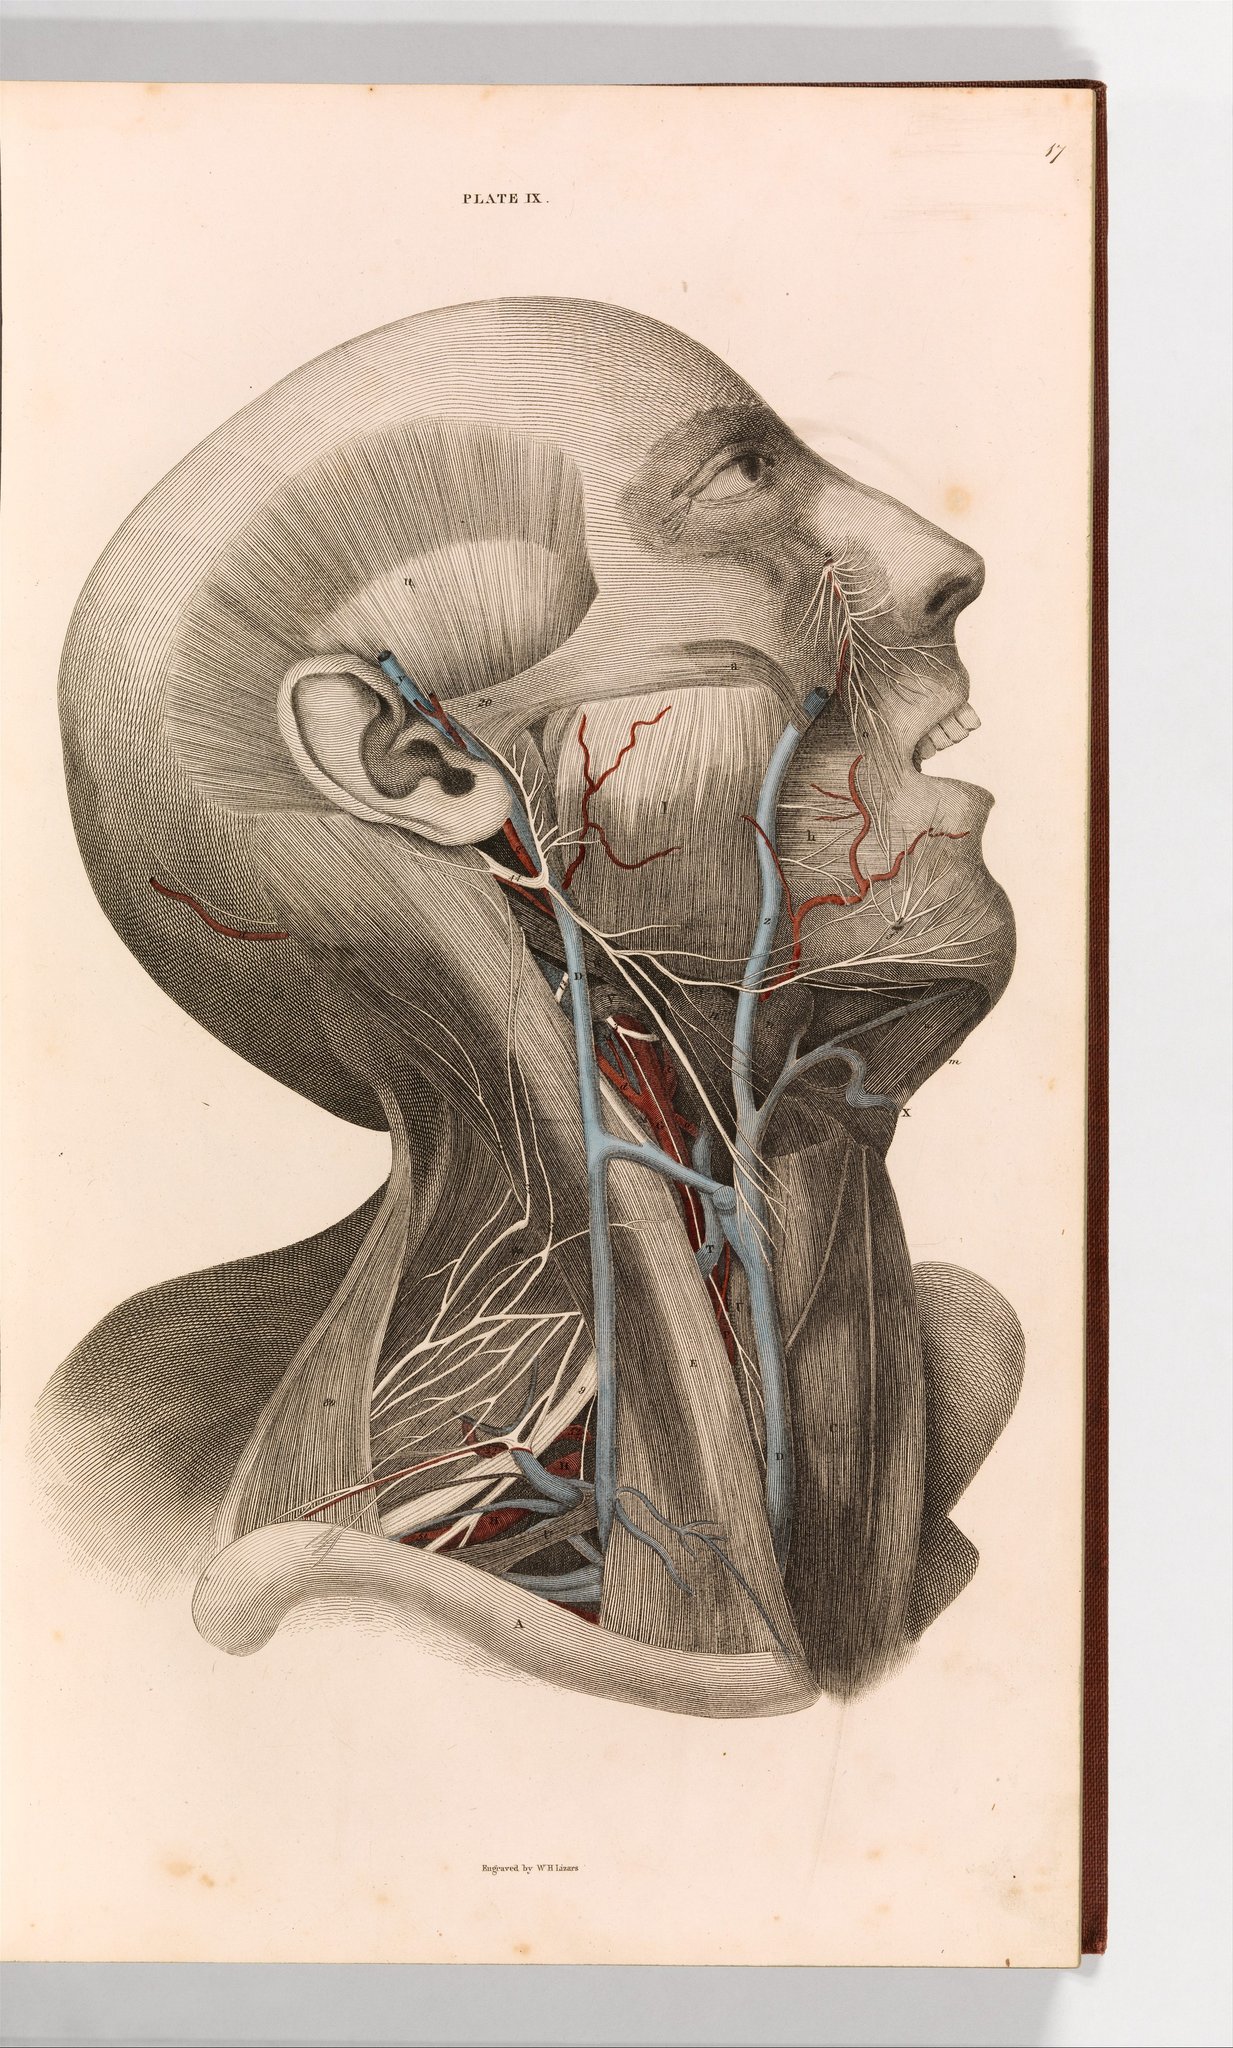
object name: book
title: A System of Anatomical Plates of the Human Body, vol. 2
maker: john lizars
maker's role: author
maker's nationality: american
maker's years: 1787-1860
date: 1822-1826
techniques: engraving, hand coloring, lithograph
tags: human anatomy